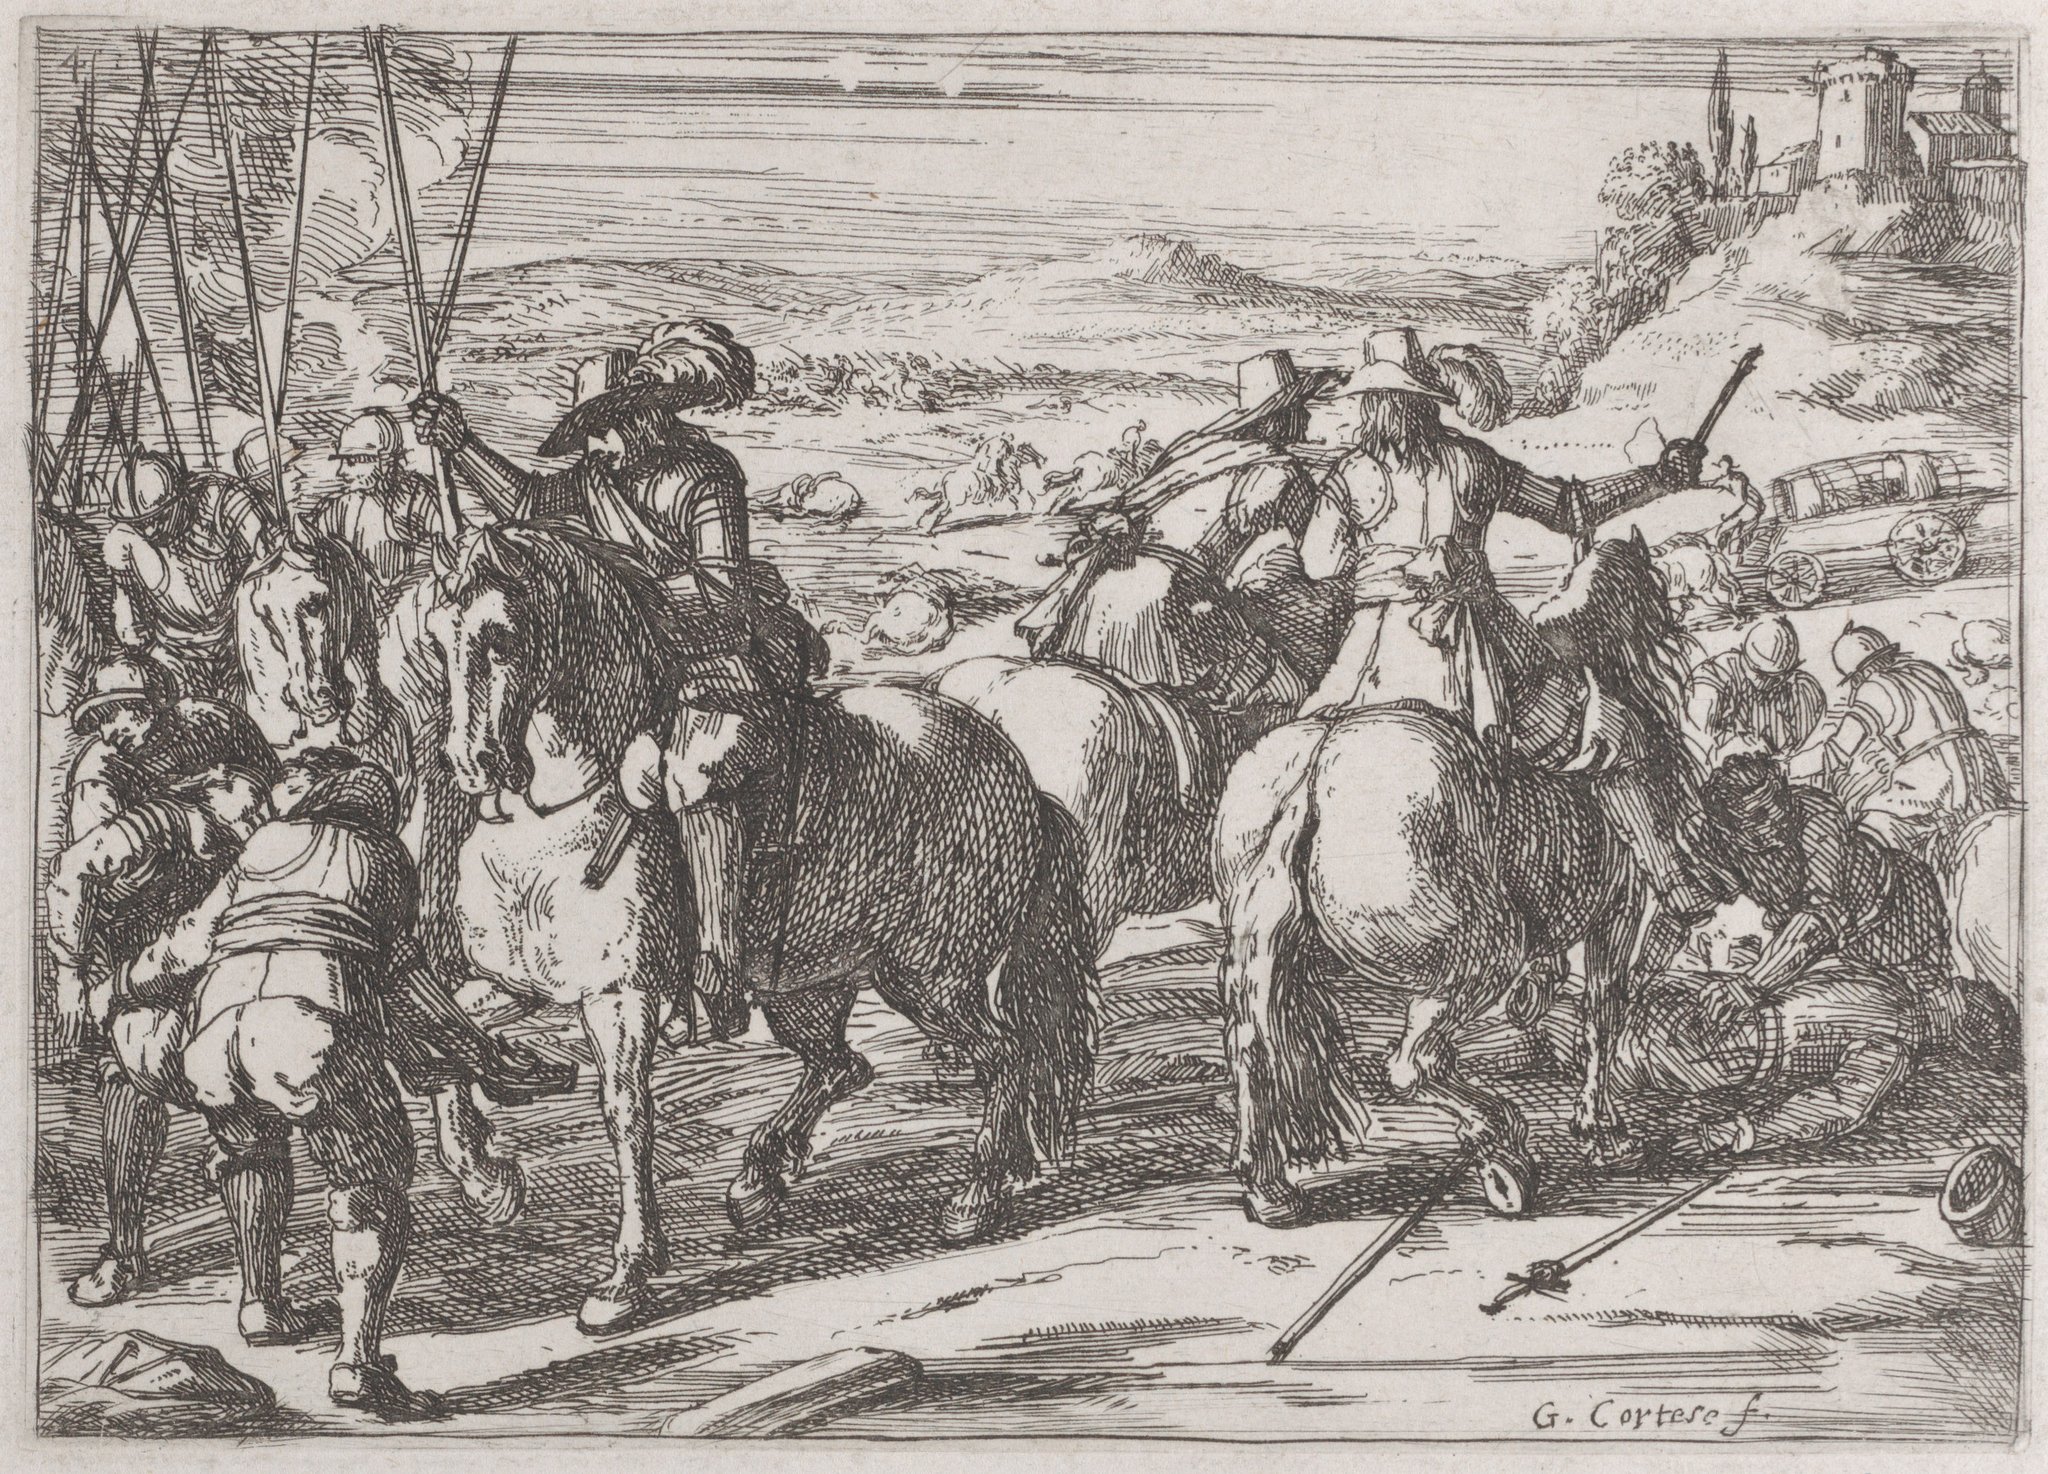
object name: print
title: Plate 4: the rescuing of dead and wounded soldiers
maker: jacques courtois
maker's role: artist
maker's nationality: french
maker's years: 1621-1676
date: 1635-1660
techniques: etching